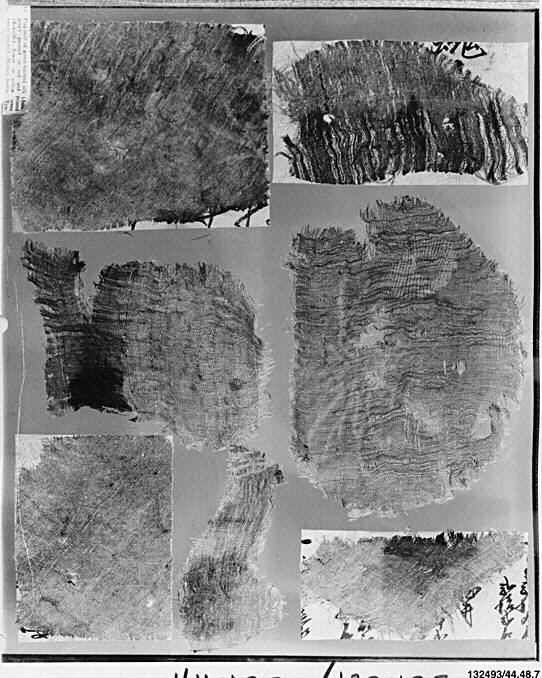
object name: fragment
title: Fragments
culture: japanese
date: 701-800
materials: textile